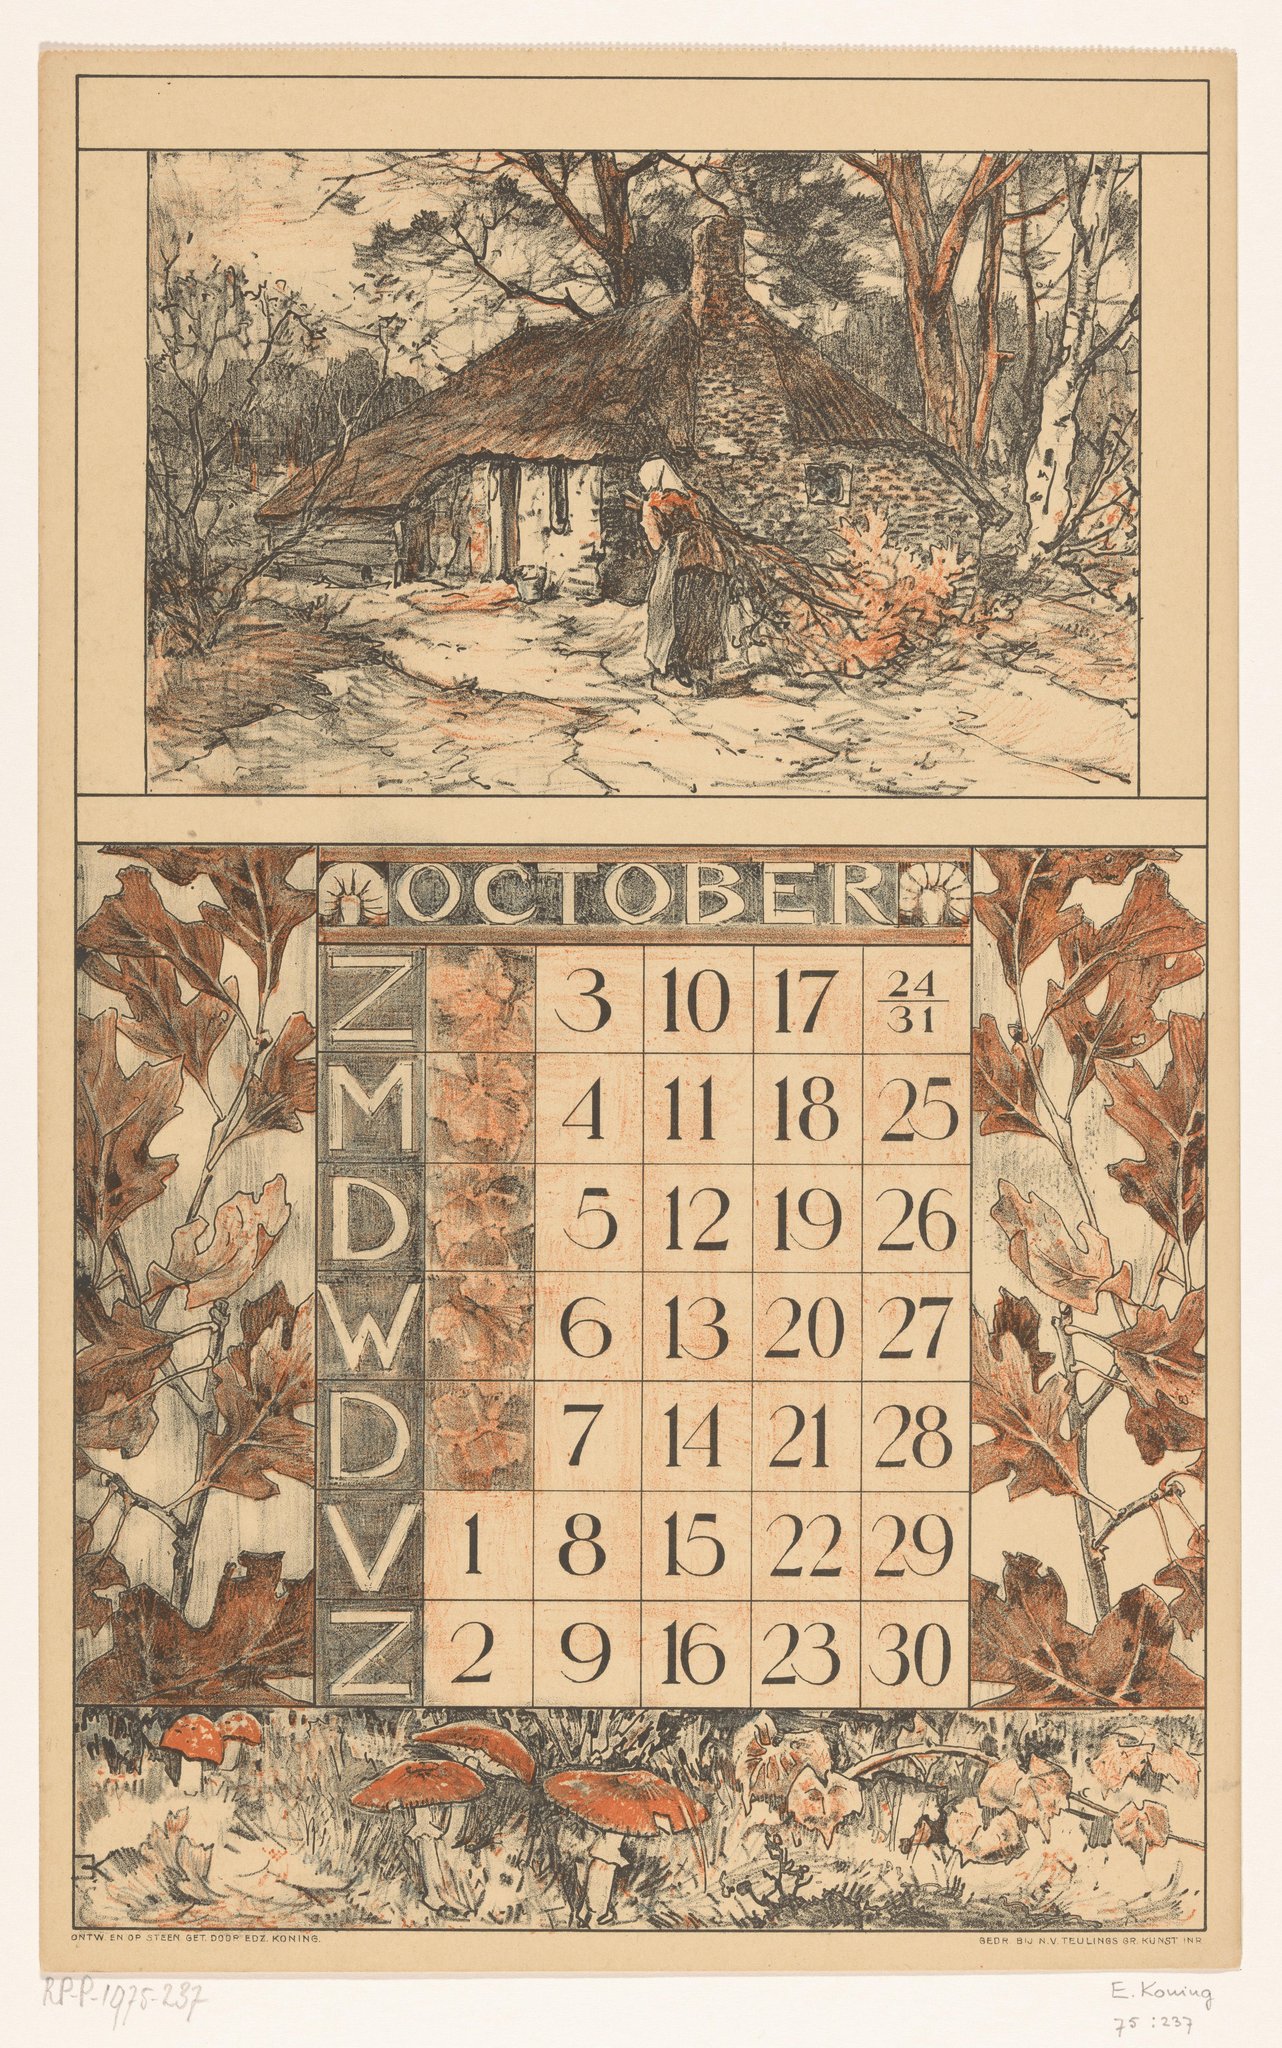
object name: calendar leaf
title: Kalenderblad voor oktober 1920 van de Nederlandsche Gist- en Spiritusfabriek in Delft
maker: edzard koning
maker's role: draughtsman, print maker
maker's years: 1869-1954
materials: paper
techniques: lithograph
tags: trees (+ leaf), woodgathering, woodgatherer, farm or solitary house in landscape, mushrooms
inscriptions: collector's mark: Lugt 2228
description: Een vierkant kader opgevuld met de dagen van de maand oktober en daaromheen herfstbladeren en paddenstoelen. Bovenaan een rechthoekig kader met daarin een vrouw op klompen die een tak sleept naar een boerderij met rieten dak en prominente schoorsteen, een zogeheten locomotiefhuisje, in of nabij Nunspeet op de Veluwe.